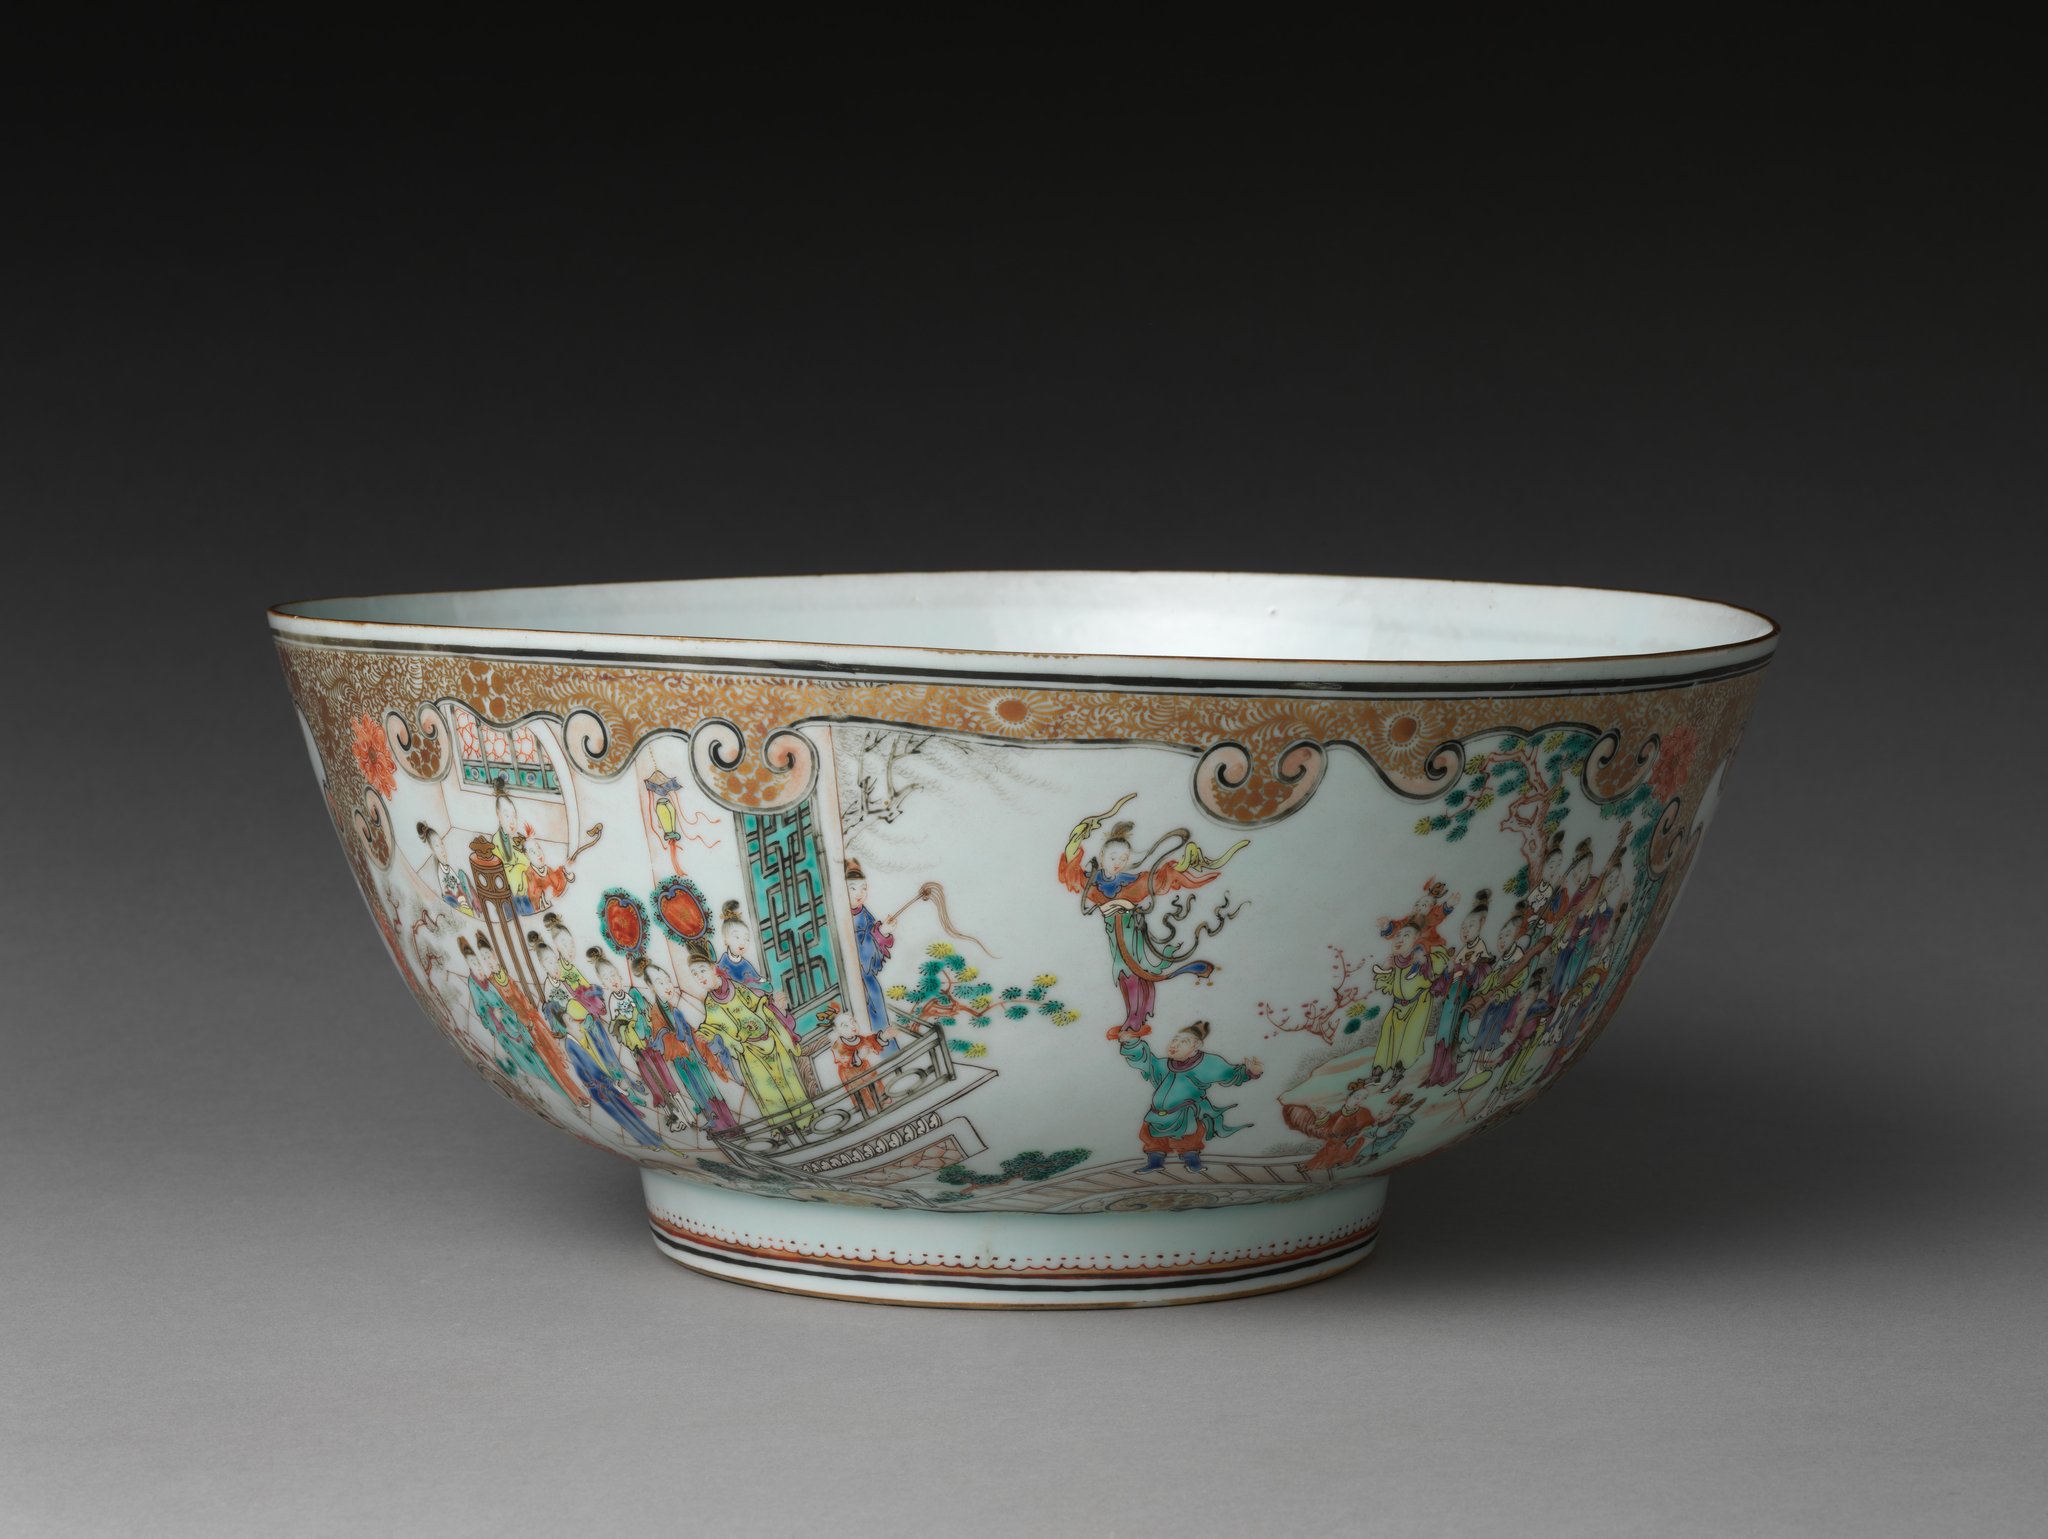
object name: bowl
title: Bowl with acrobatic performance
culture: chinese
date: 1644-1911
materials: enamel, porcelain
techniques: overglaze, painting, polychrome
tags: men,women